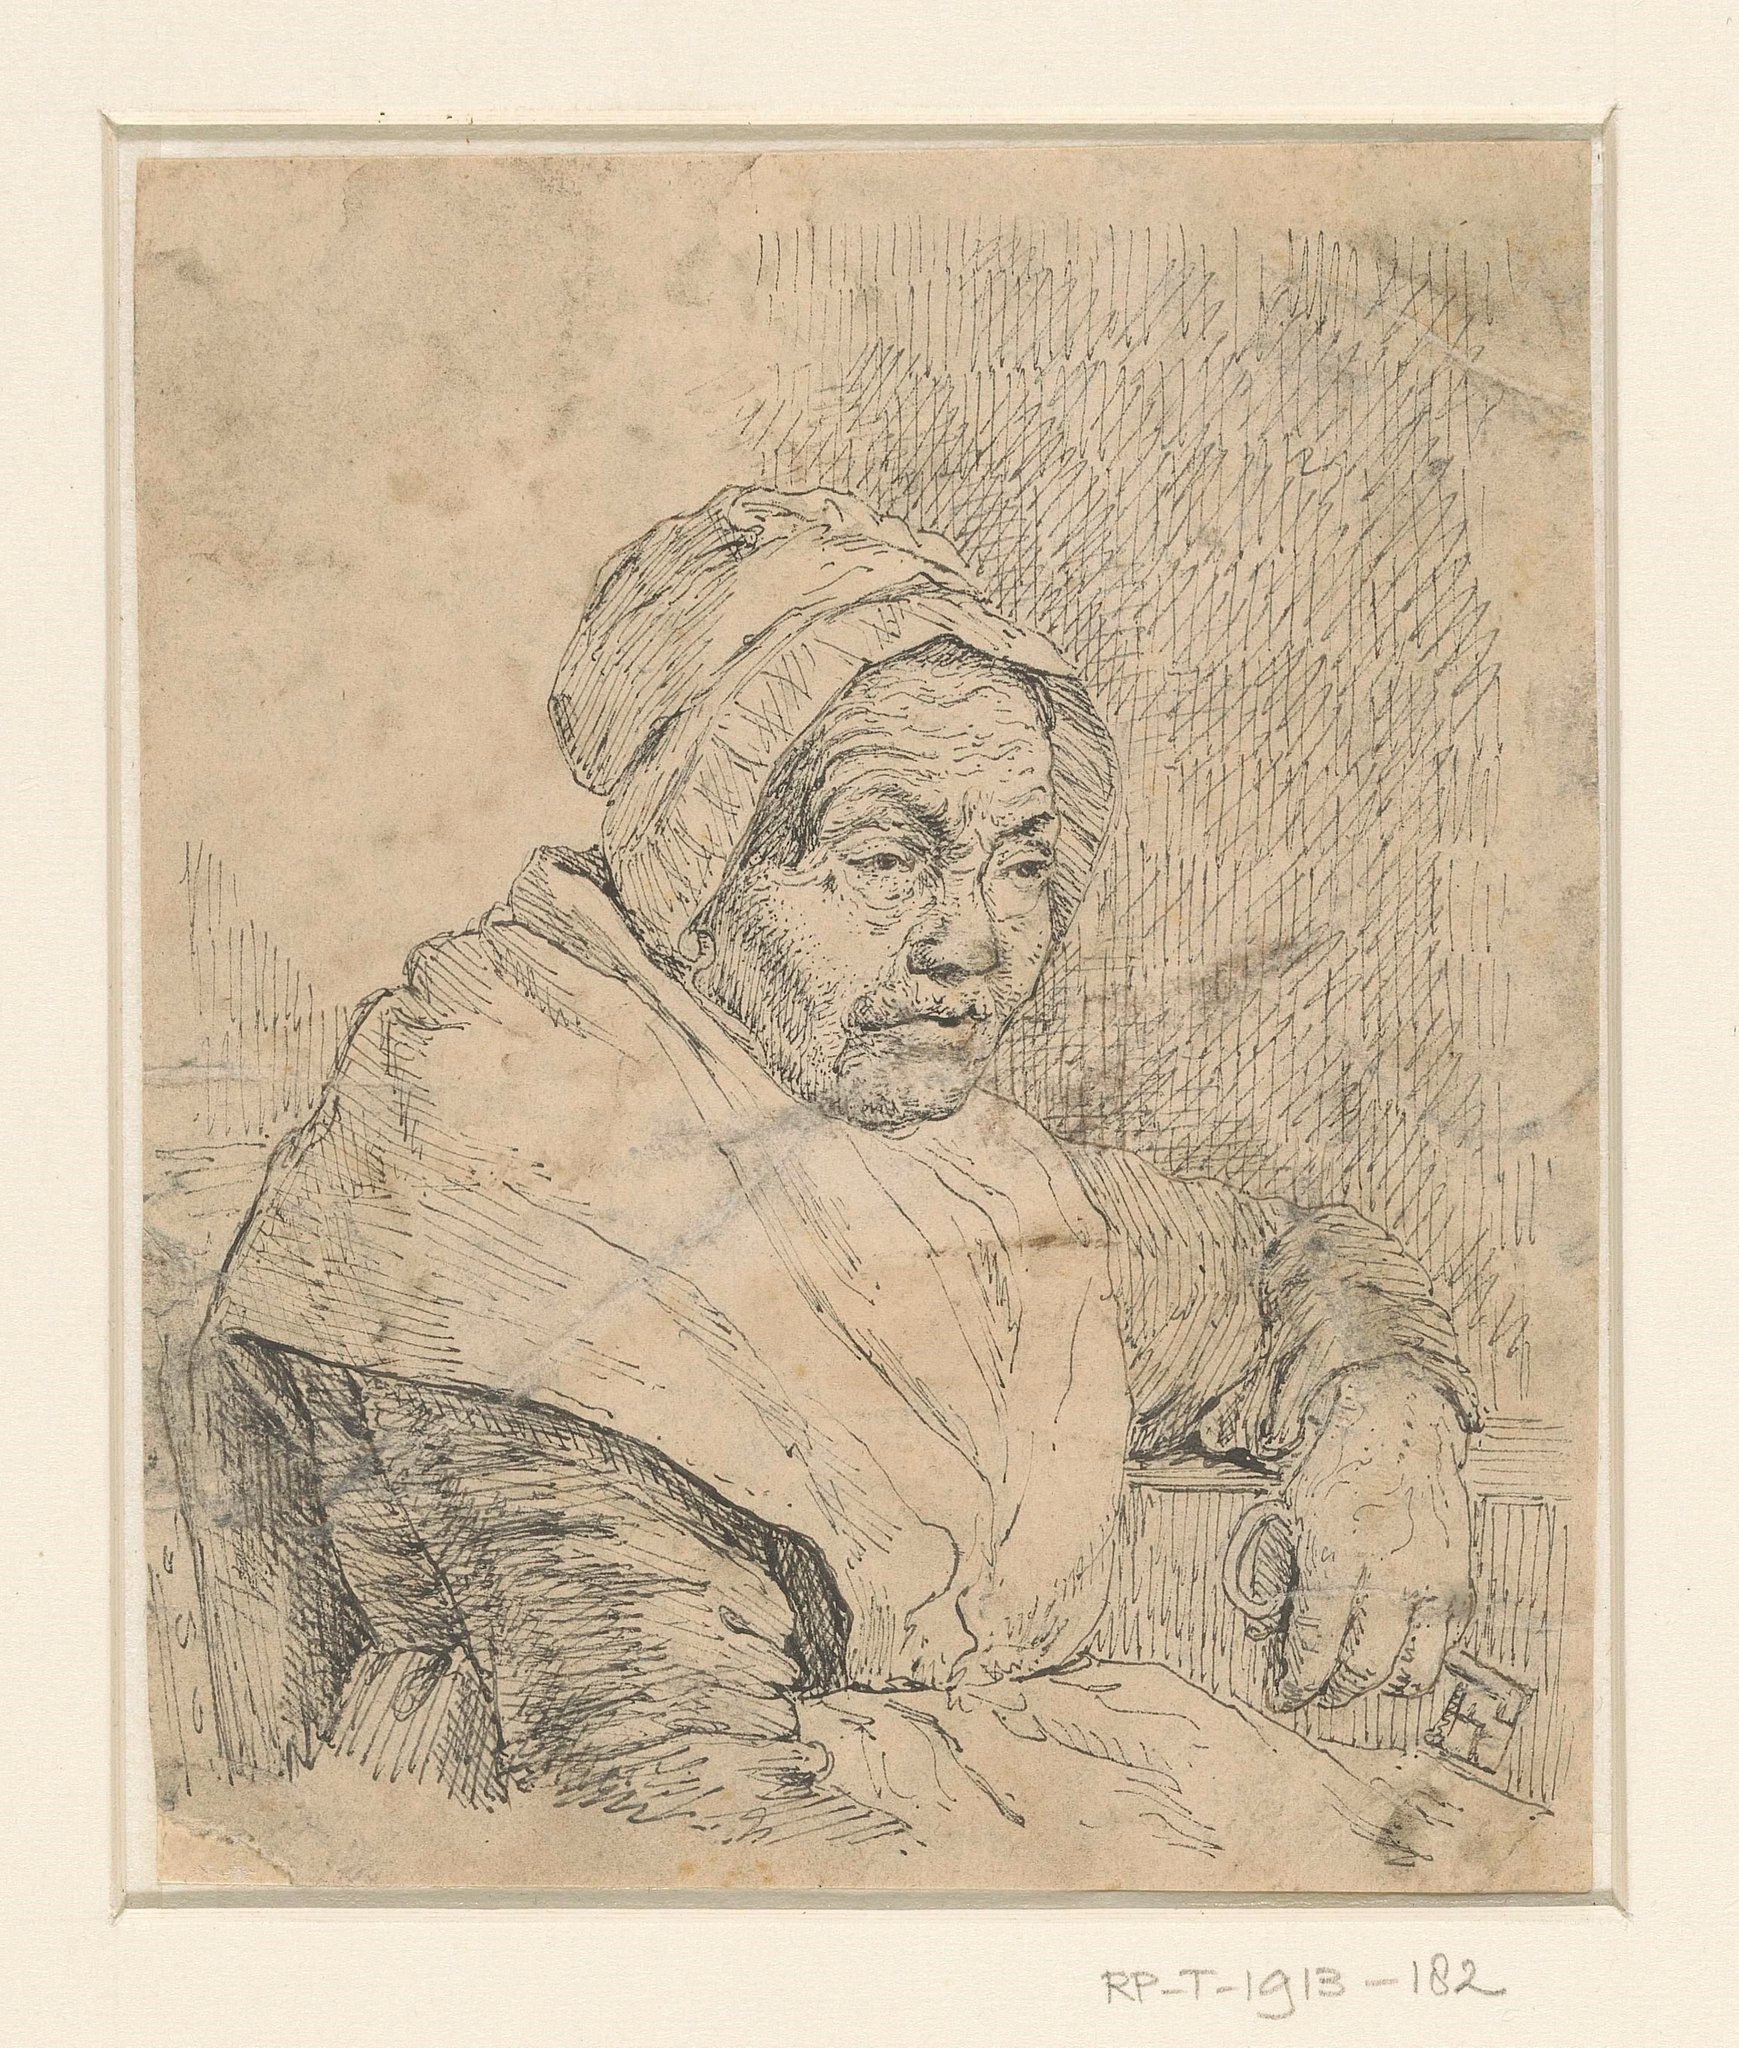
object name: drawing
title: Oude vrouw met sleutel in de linkerhand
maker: pieter christoffel wonder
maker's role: draughtsman, painter, print maker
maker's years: 1780-1852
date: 1790-1852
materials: ink, paper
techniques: pen